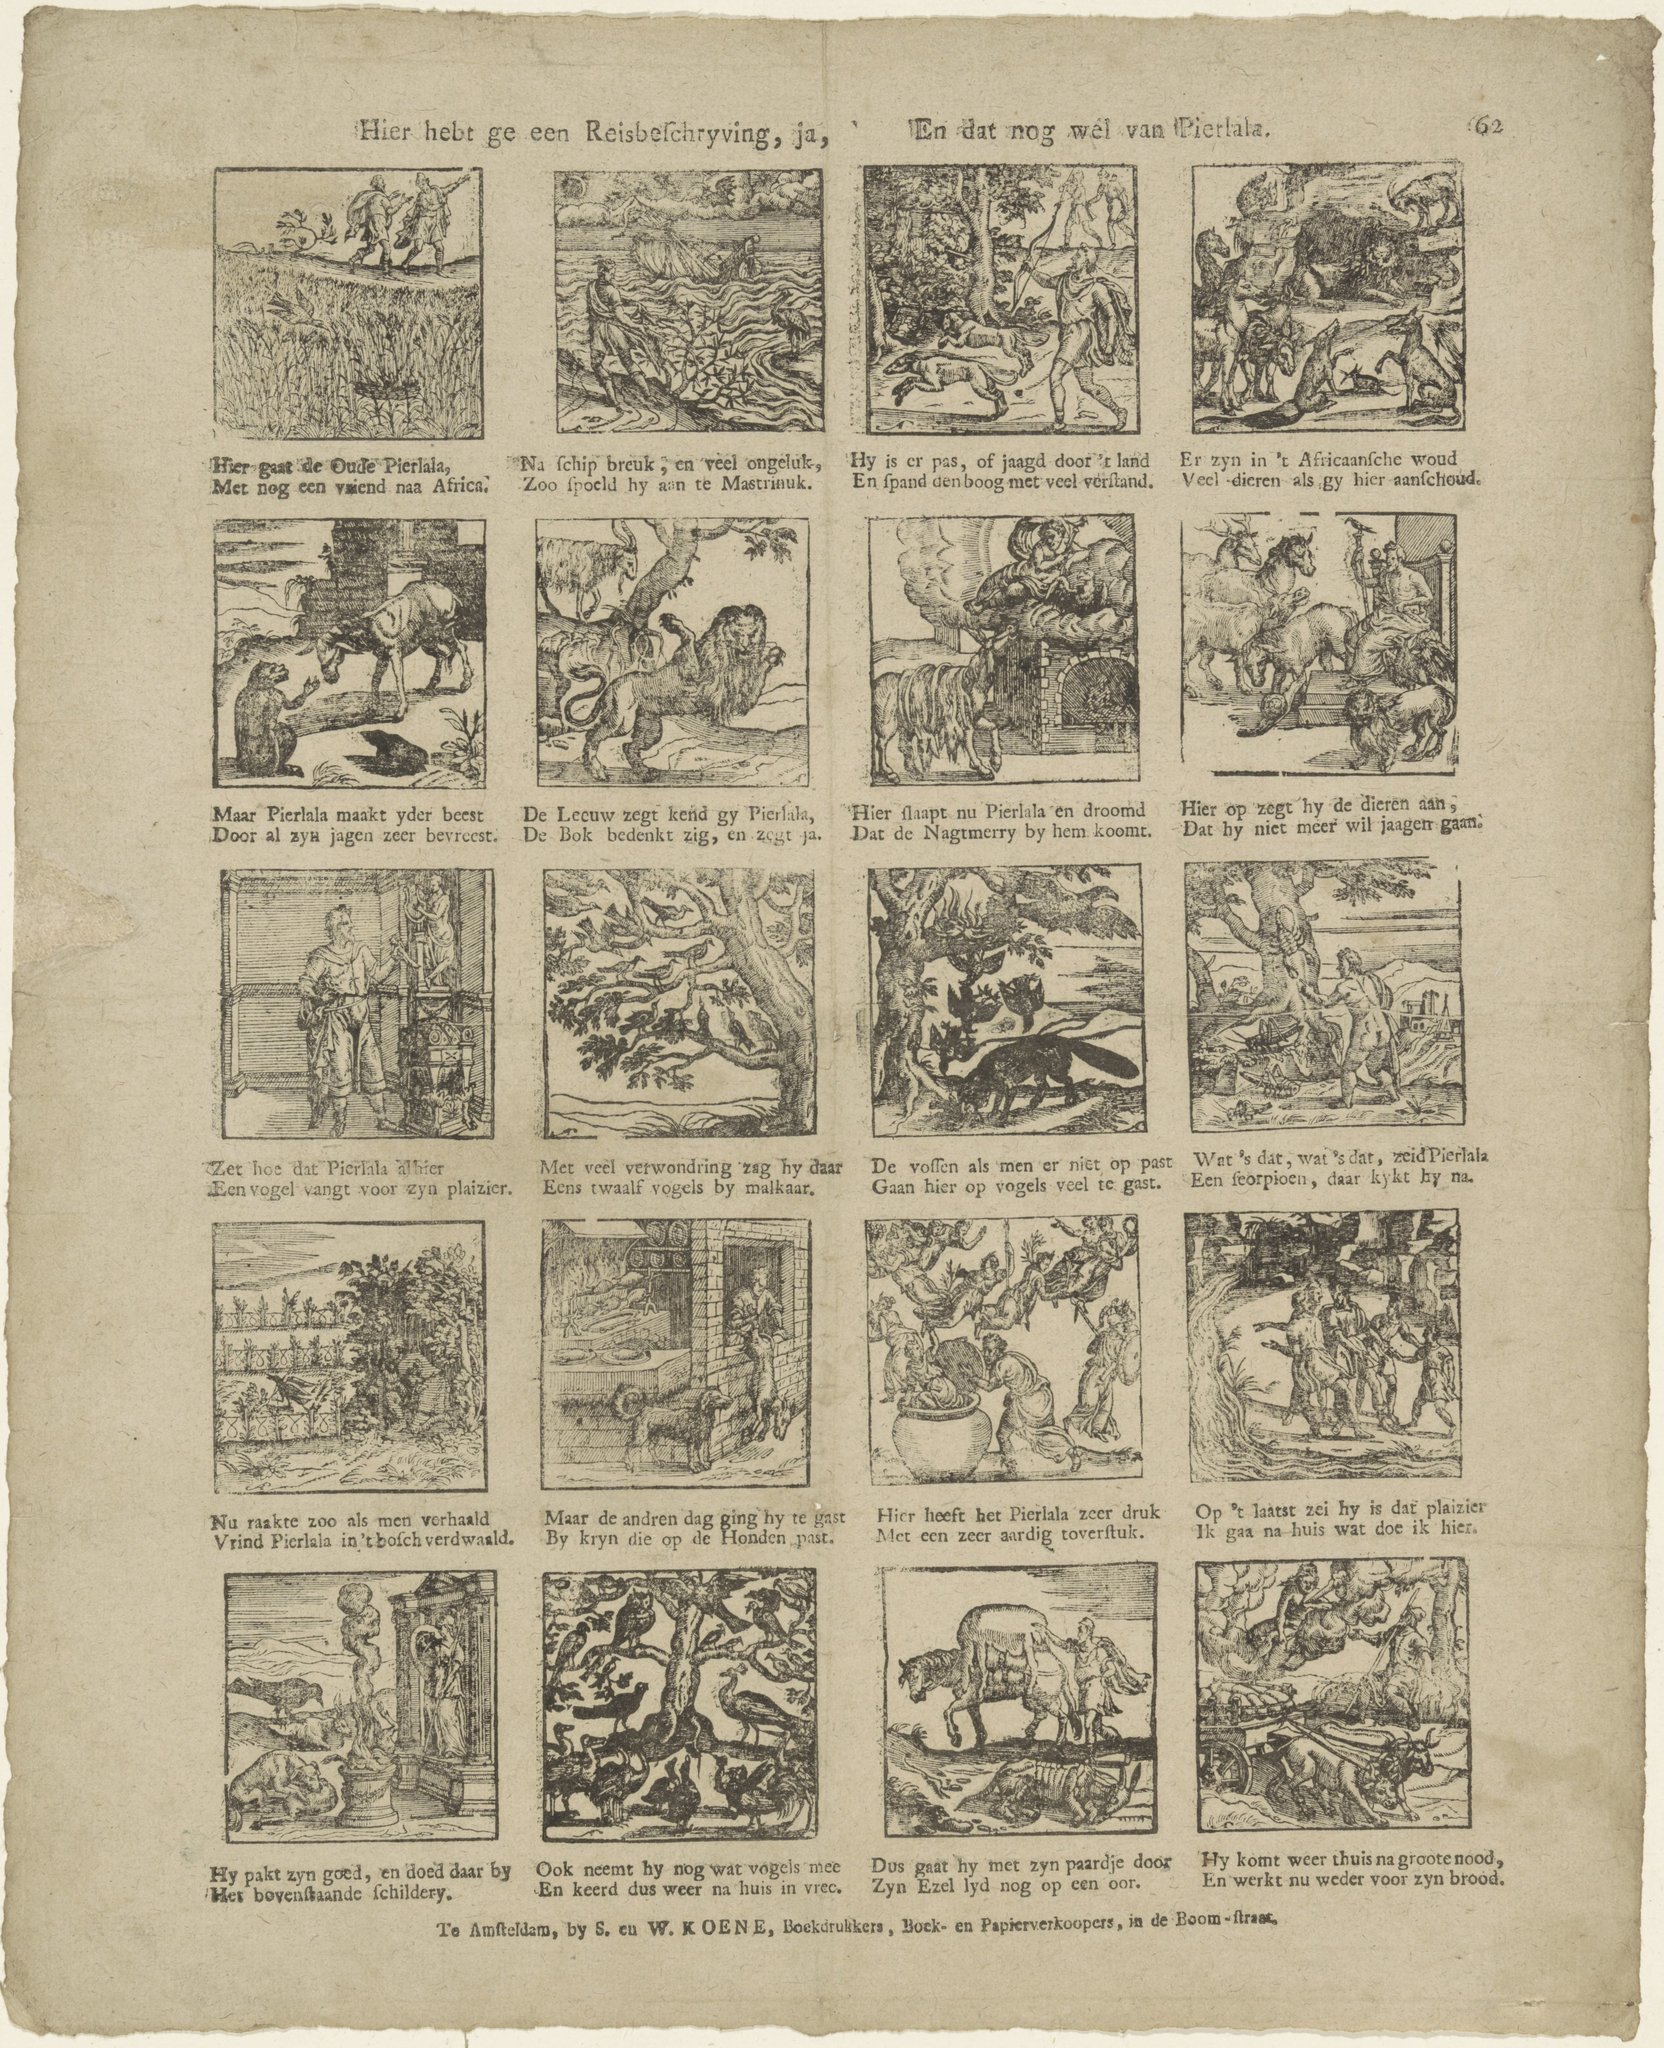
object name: print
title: Hier hebt ge een reisbeschryving, ja, / En dat nog wel van Pierlala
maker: Anonymous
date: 1800-1810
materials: paper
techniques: colour, letterpress printing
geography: netherlands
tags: fables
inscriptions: collector's mark: Lugt 2760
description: Blad met 20 voorstellingen uit de Honderd Fabels (Centum fabulae ex antiquis autoribus delectae, et carminibus explicatae) van Gabriele Faerno. Onder elke afbeelding een tweeregelig vers. Genummerd rechtsboven: 62.